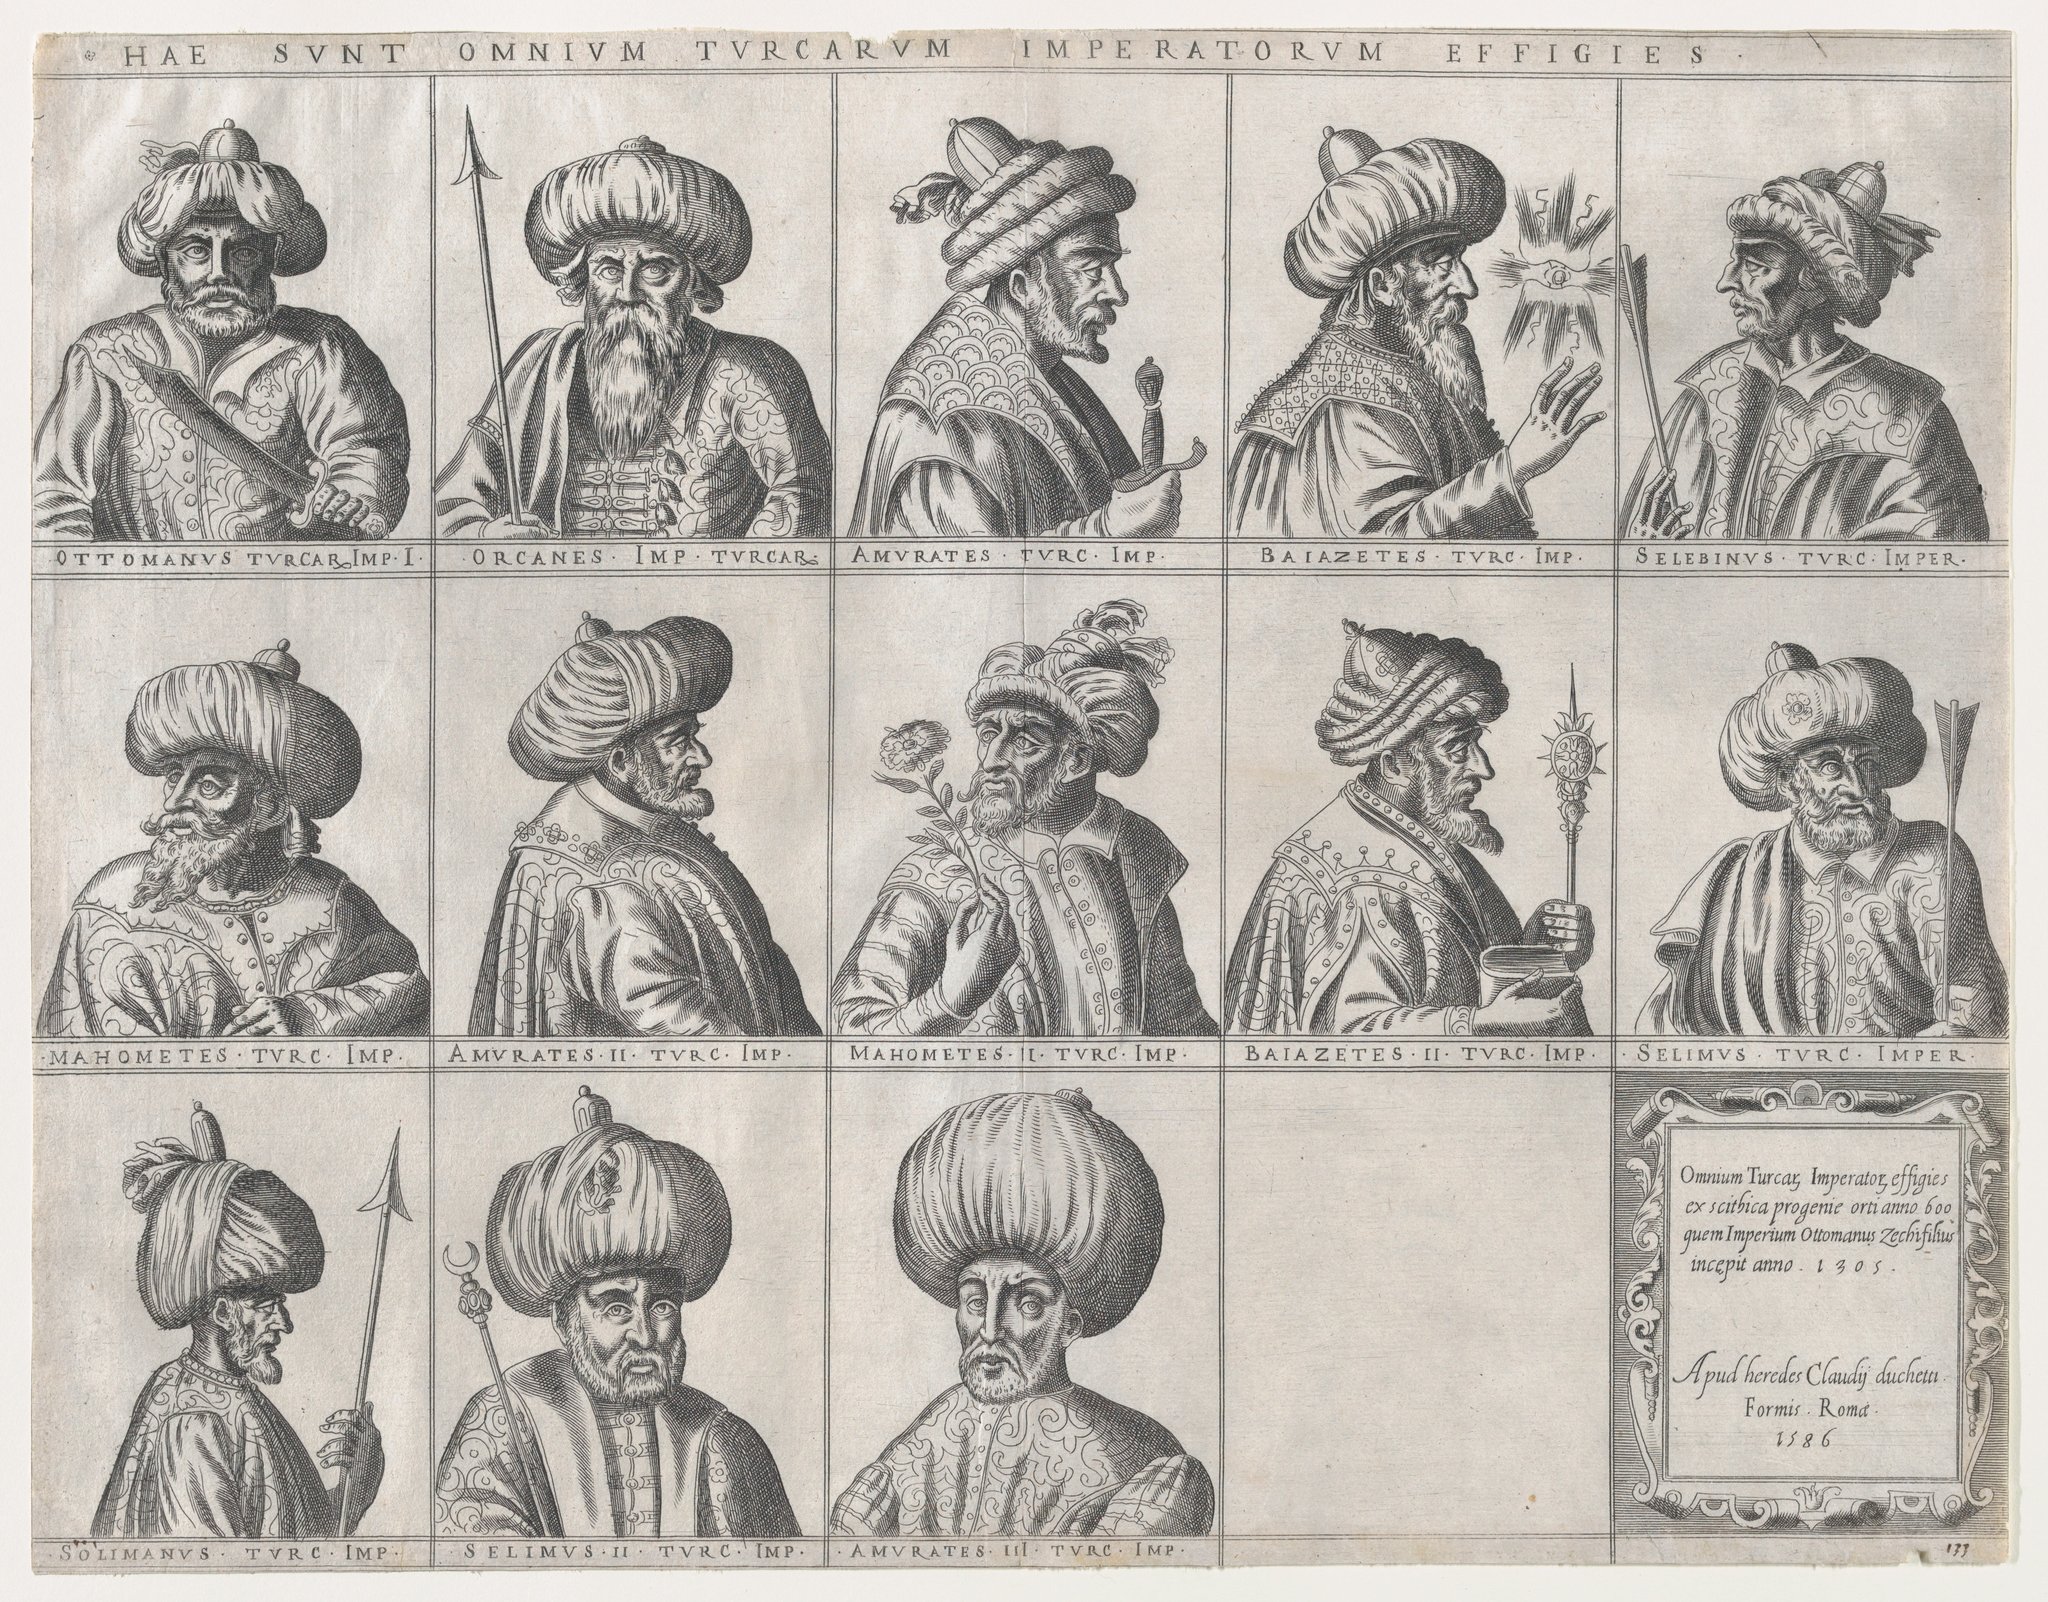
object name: print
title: Portraits of Turkish Sultans, from "Speculum Romanae Magnificentiae"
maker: Anonymous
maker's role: artist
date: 1567-1600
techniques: engraving, etching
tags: men,portraits